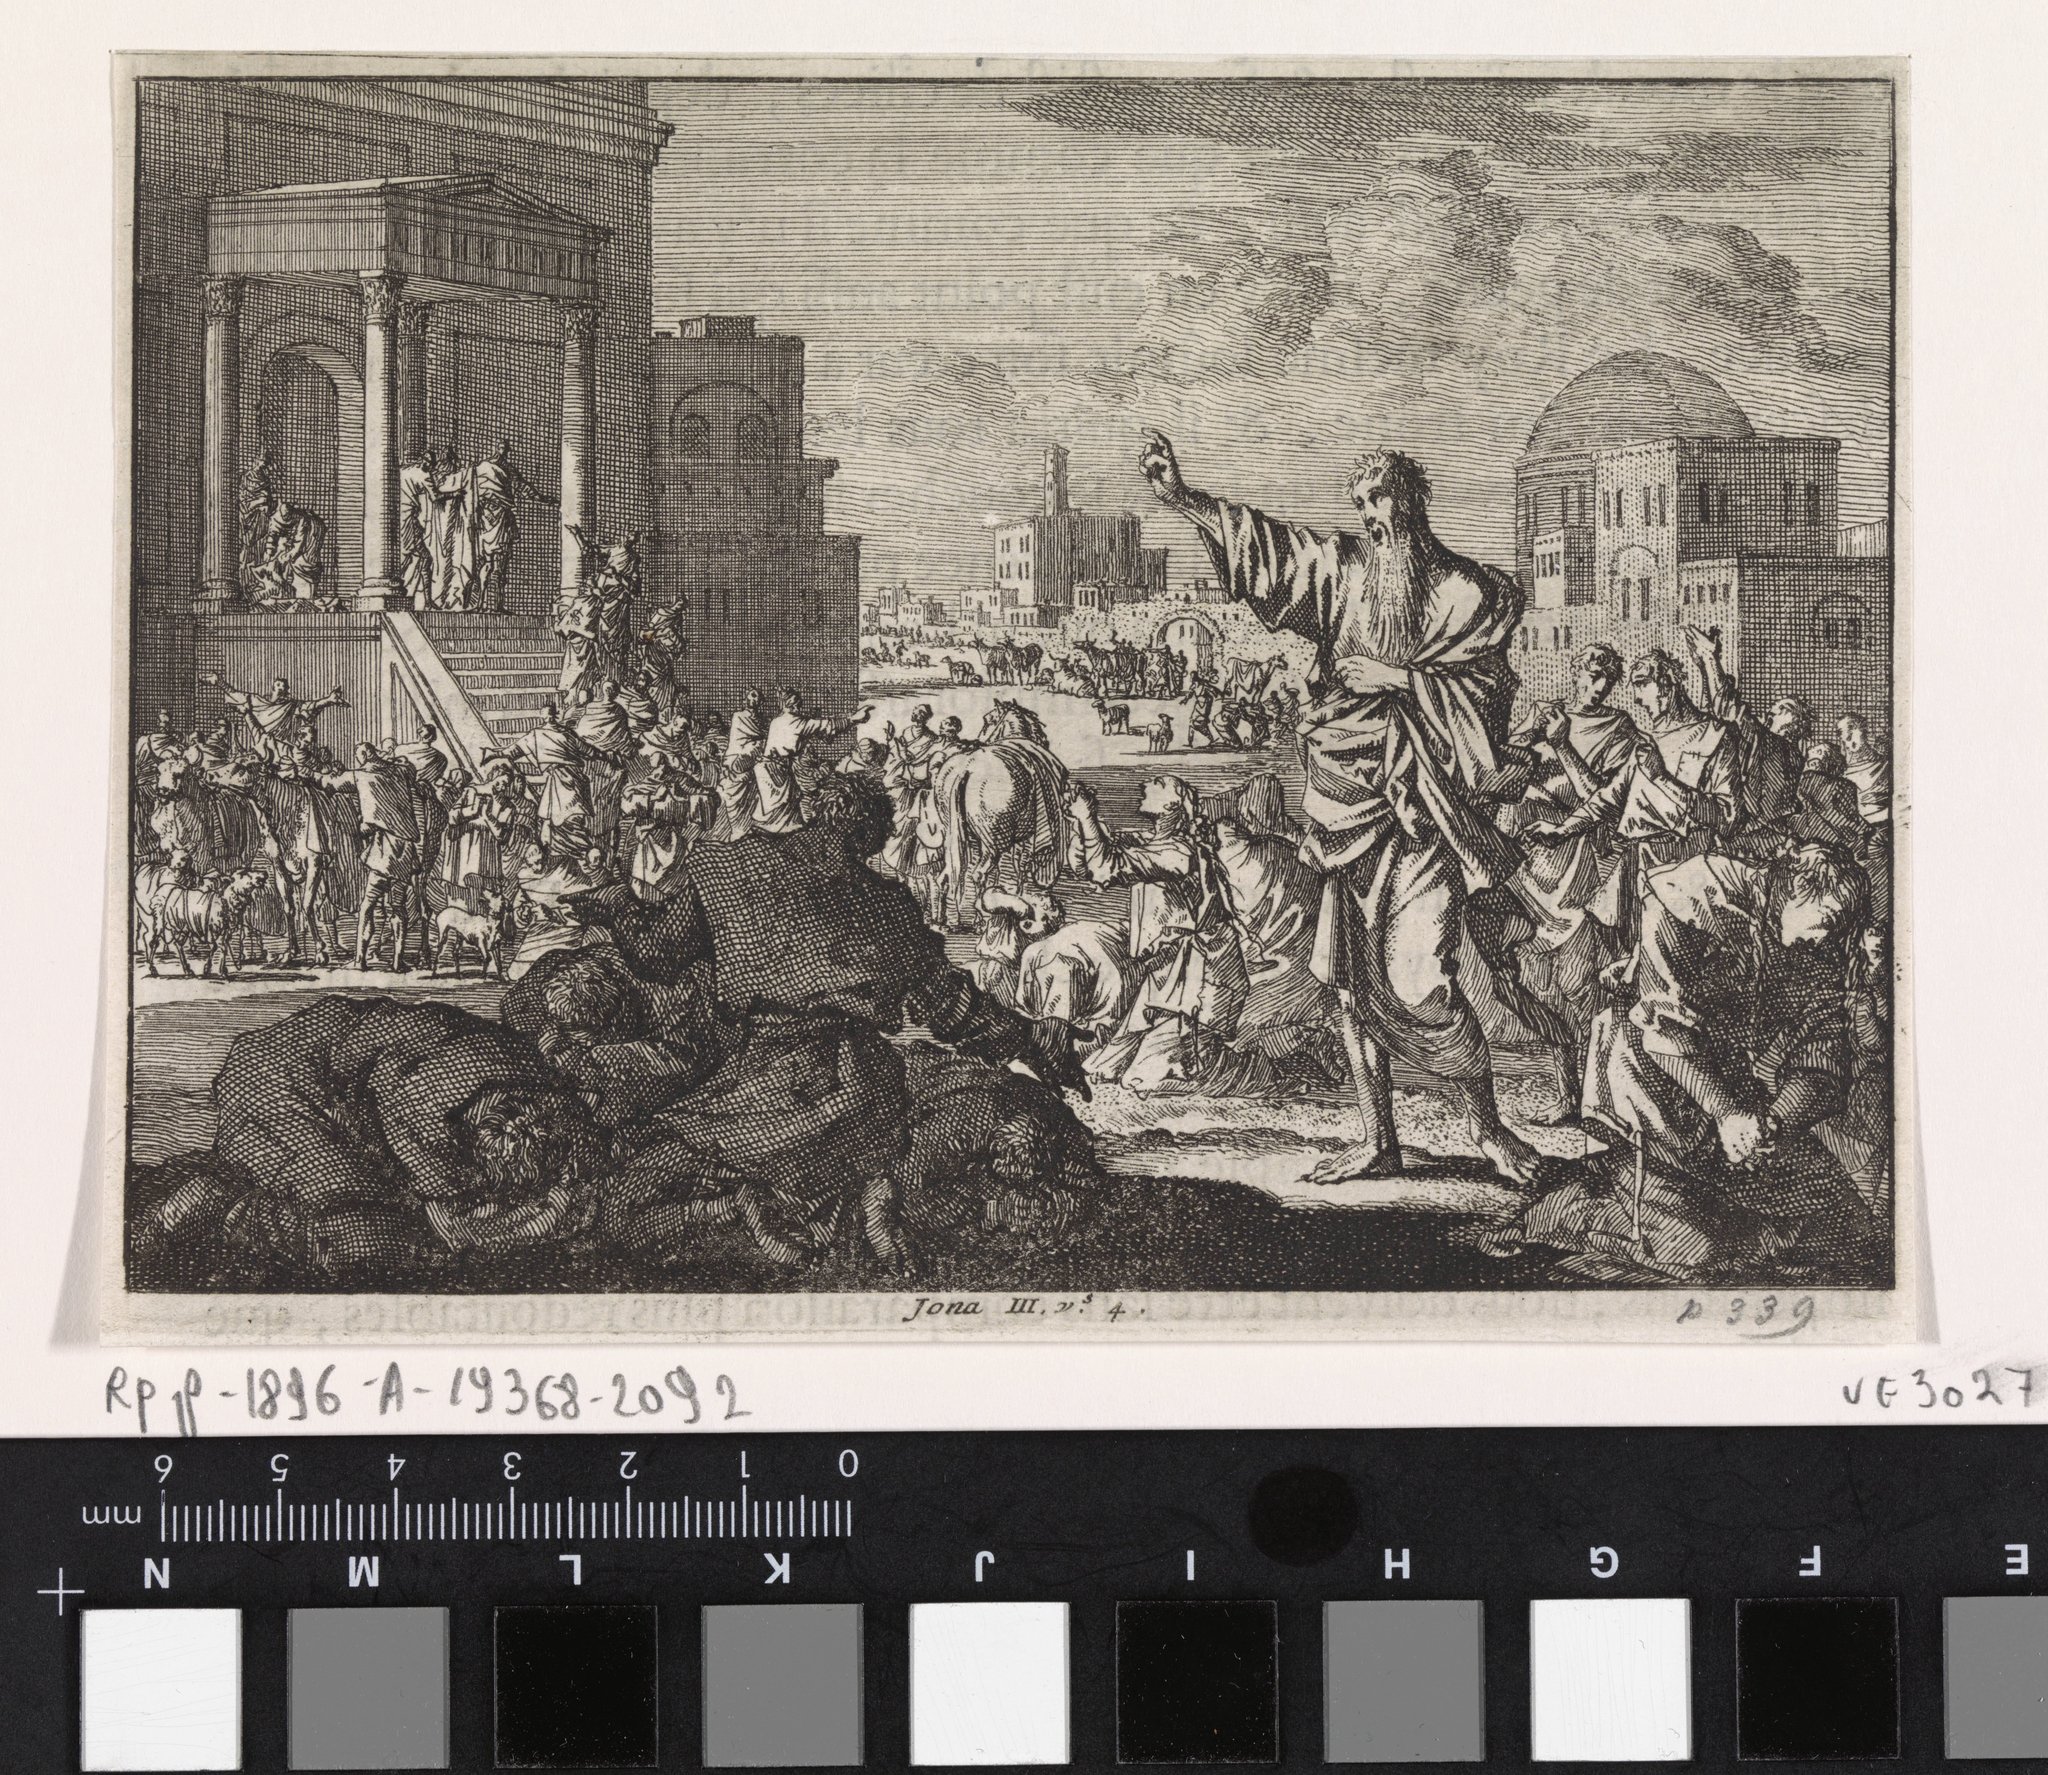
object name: book illustration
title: Jona voorspelt de ondergang van Nineve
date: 1703-1762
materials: paper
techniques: etching, letterpress printing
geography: haarlem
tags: when jonah arrives in the city of nineveh he foretells its destruction in forty days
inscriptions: collector's mark: Lugt 2228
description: De prent komt een eerste keer voor als boekillustratie voor David Martin. Historie des Ouden en Nieuwen Testaments. Amsterdam, Pieter Mortier, 1703. Deel I. De boekillustraties voor de Mortierbijbel hebben verschillende staten en kopieën, waarbij de chronologische volgorde moeilijk te achterhalen valt. Als boekillustraties werden ze bovendien herhaaldelijk opnieuw gebruikt voor andere boekwerken.